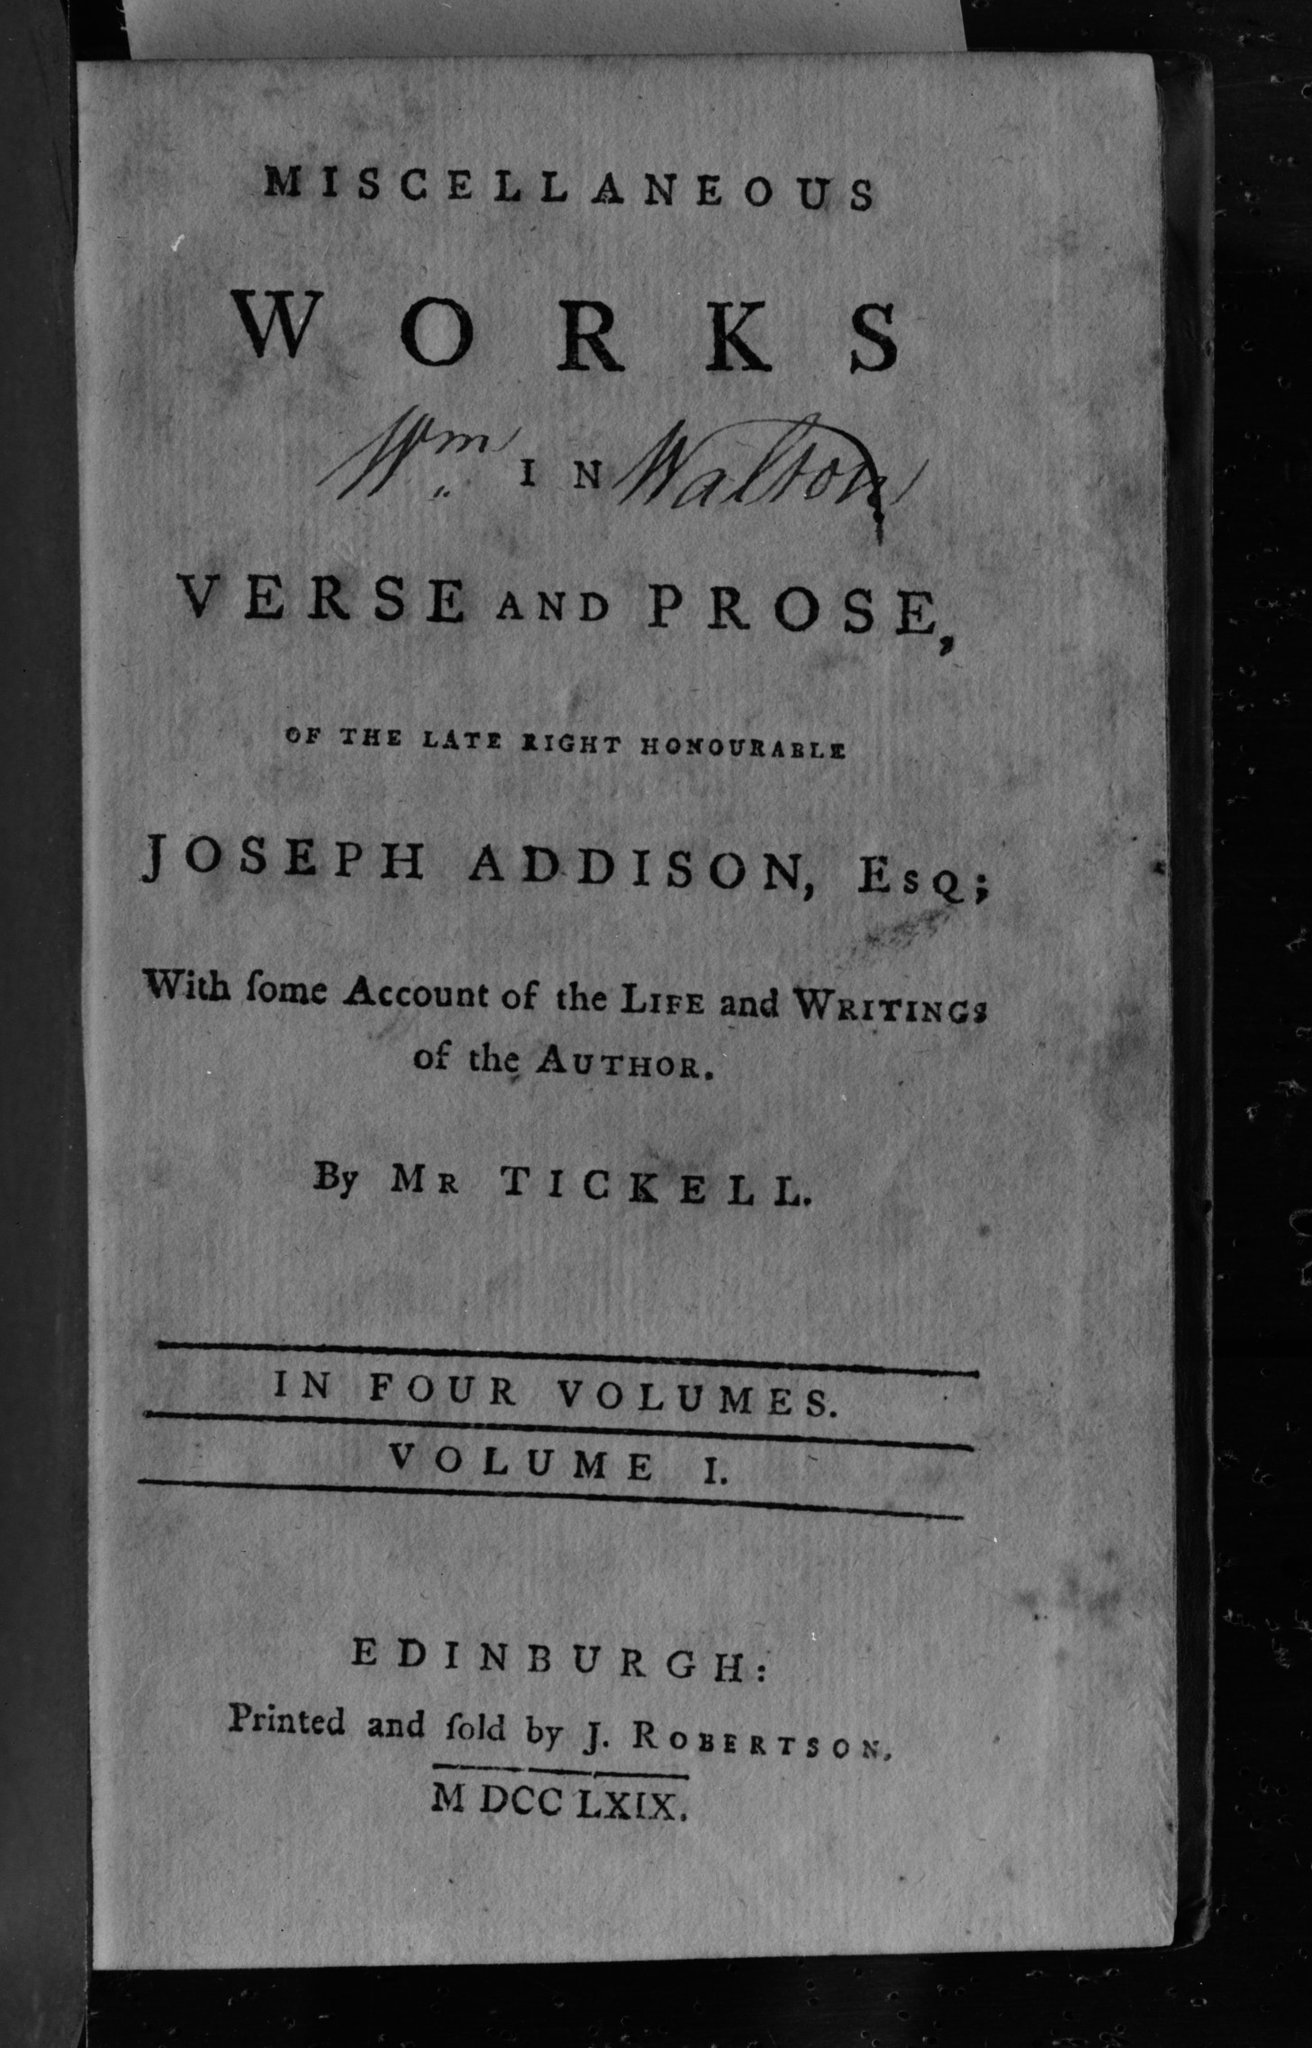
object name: book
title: Book: Miscellaneous Works in Verse and Prose (Volume I of four volumes)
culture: scottish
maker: joseph addison, esq.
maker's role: author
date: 1769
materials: paper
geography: scotland